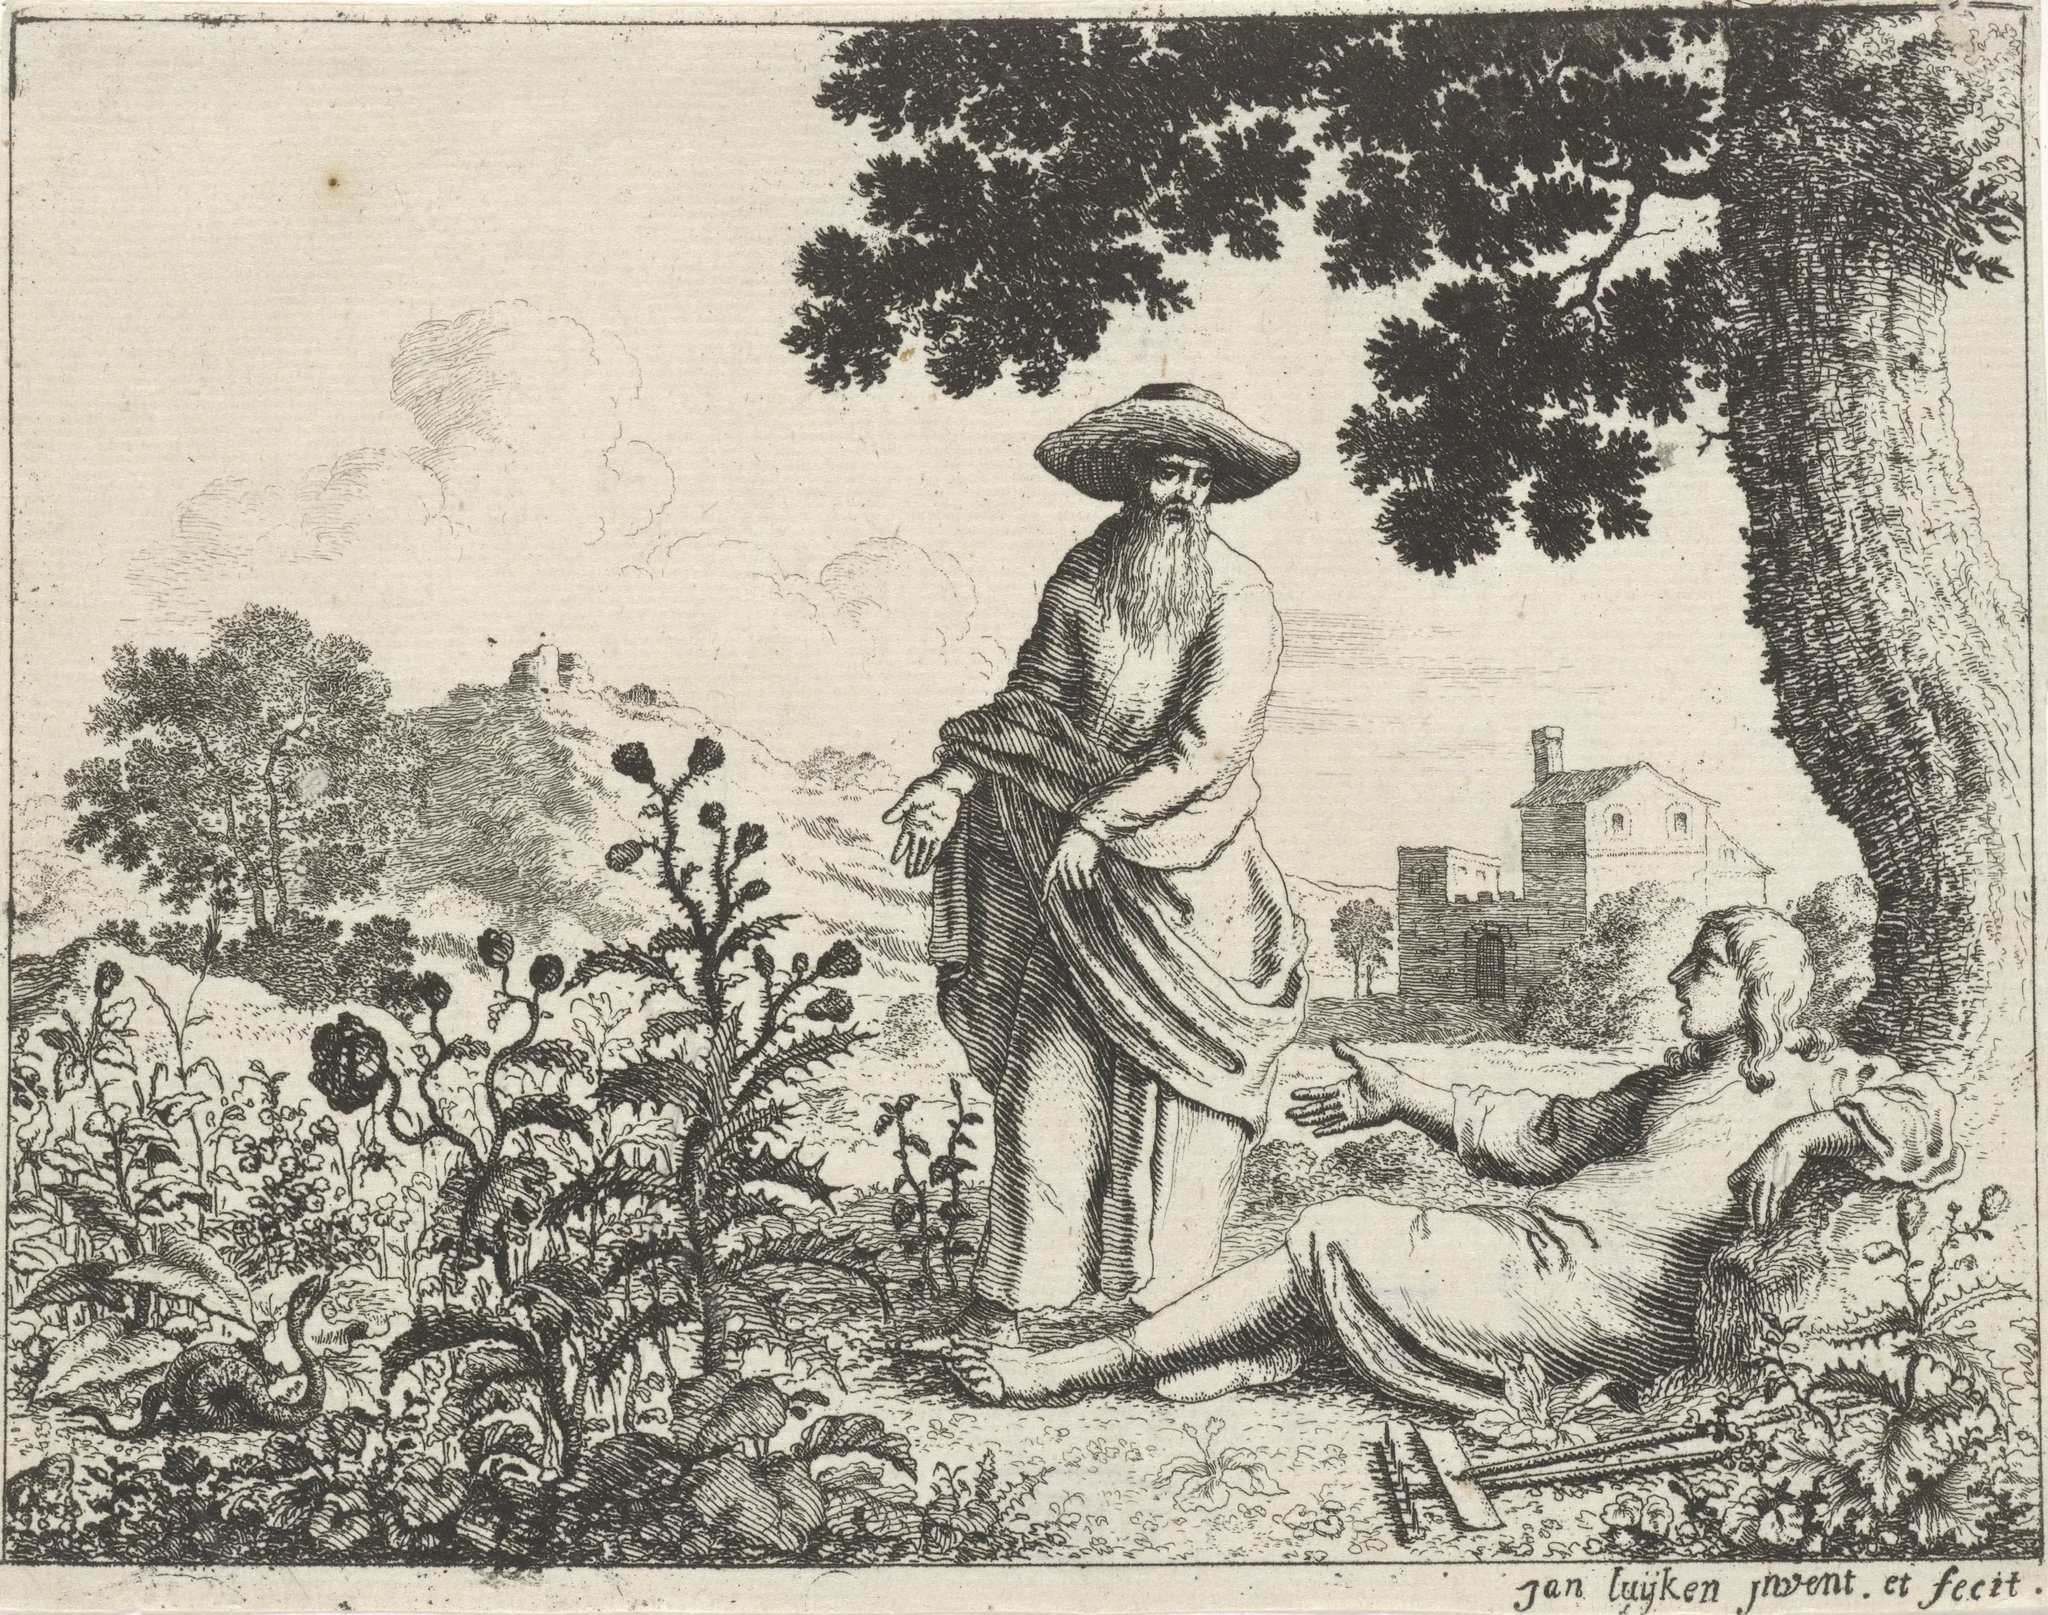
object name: print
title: Waerneminghs Nuttigheydt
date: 1678-1679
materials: paper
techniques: etching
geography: amsterdam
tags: snakes, farmers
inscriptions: collector's mark: Lugt 2228